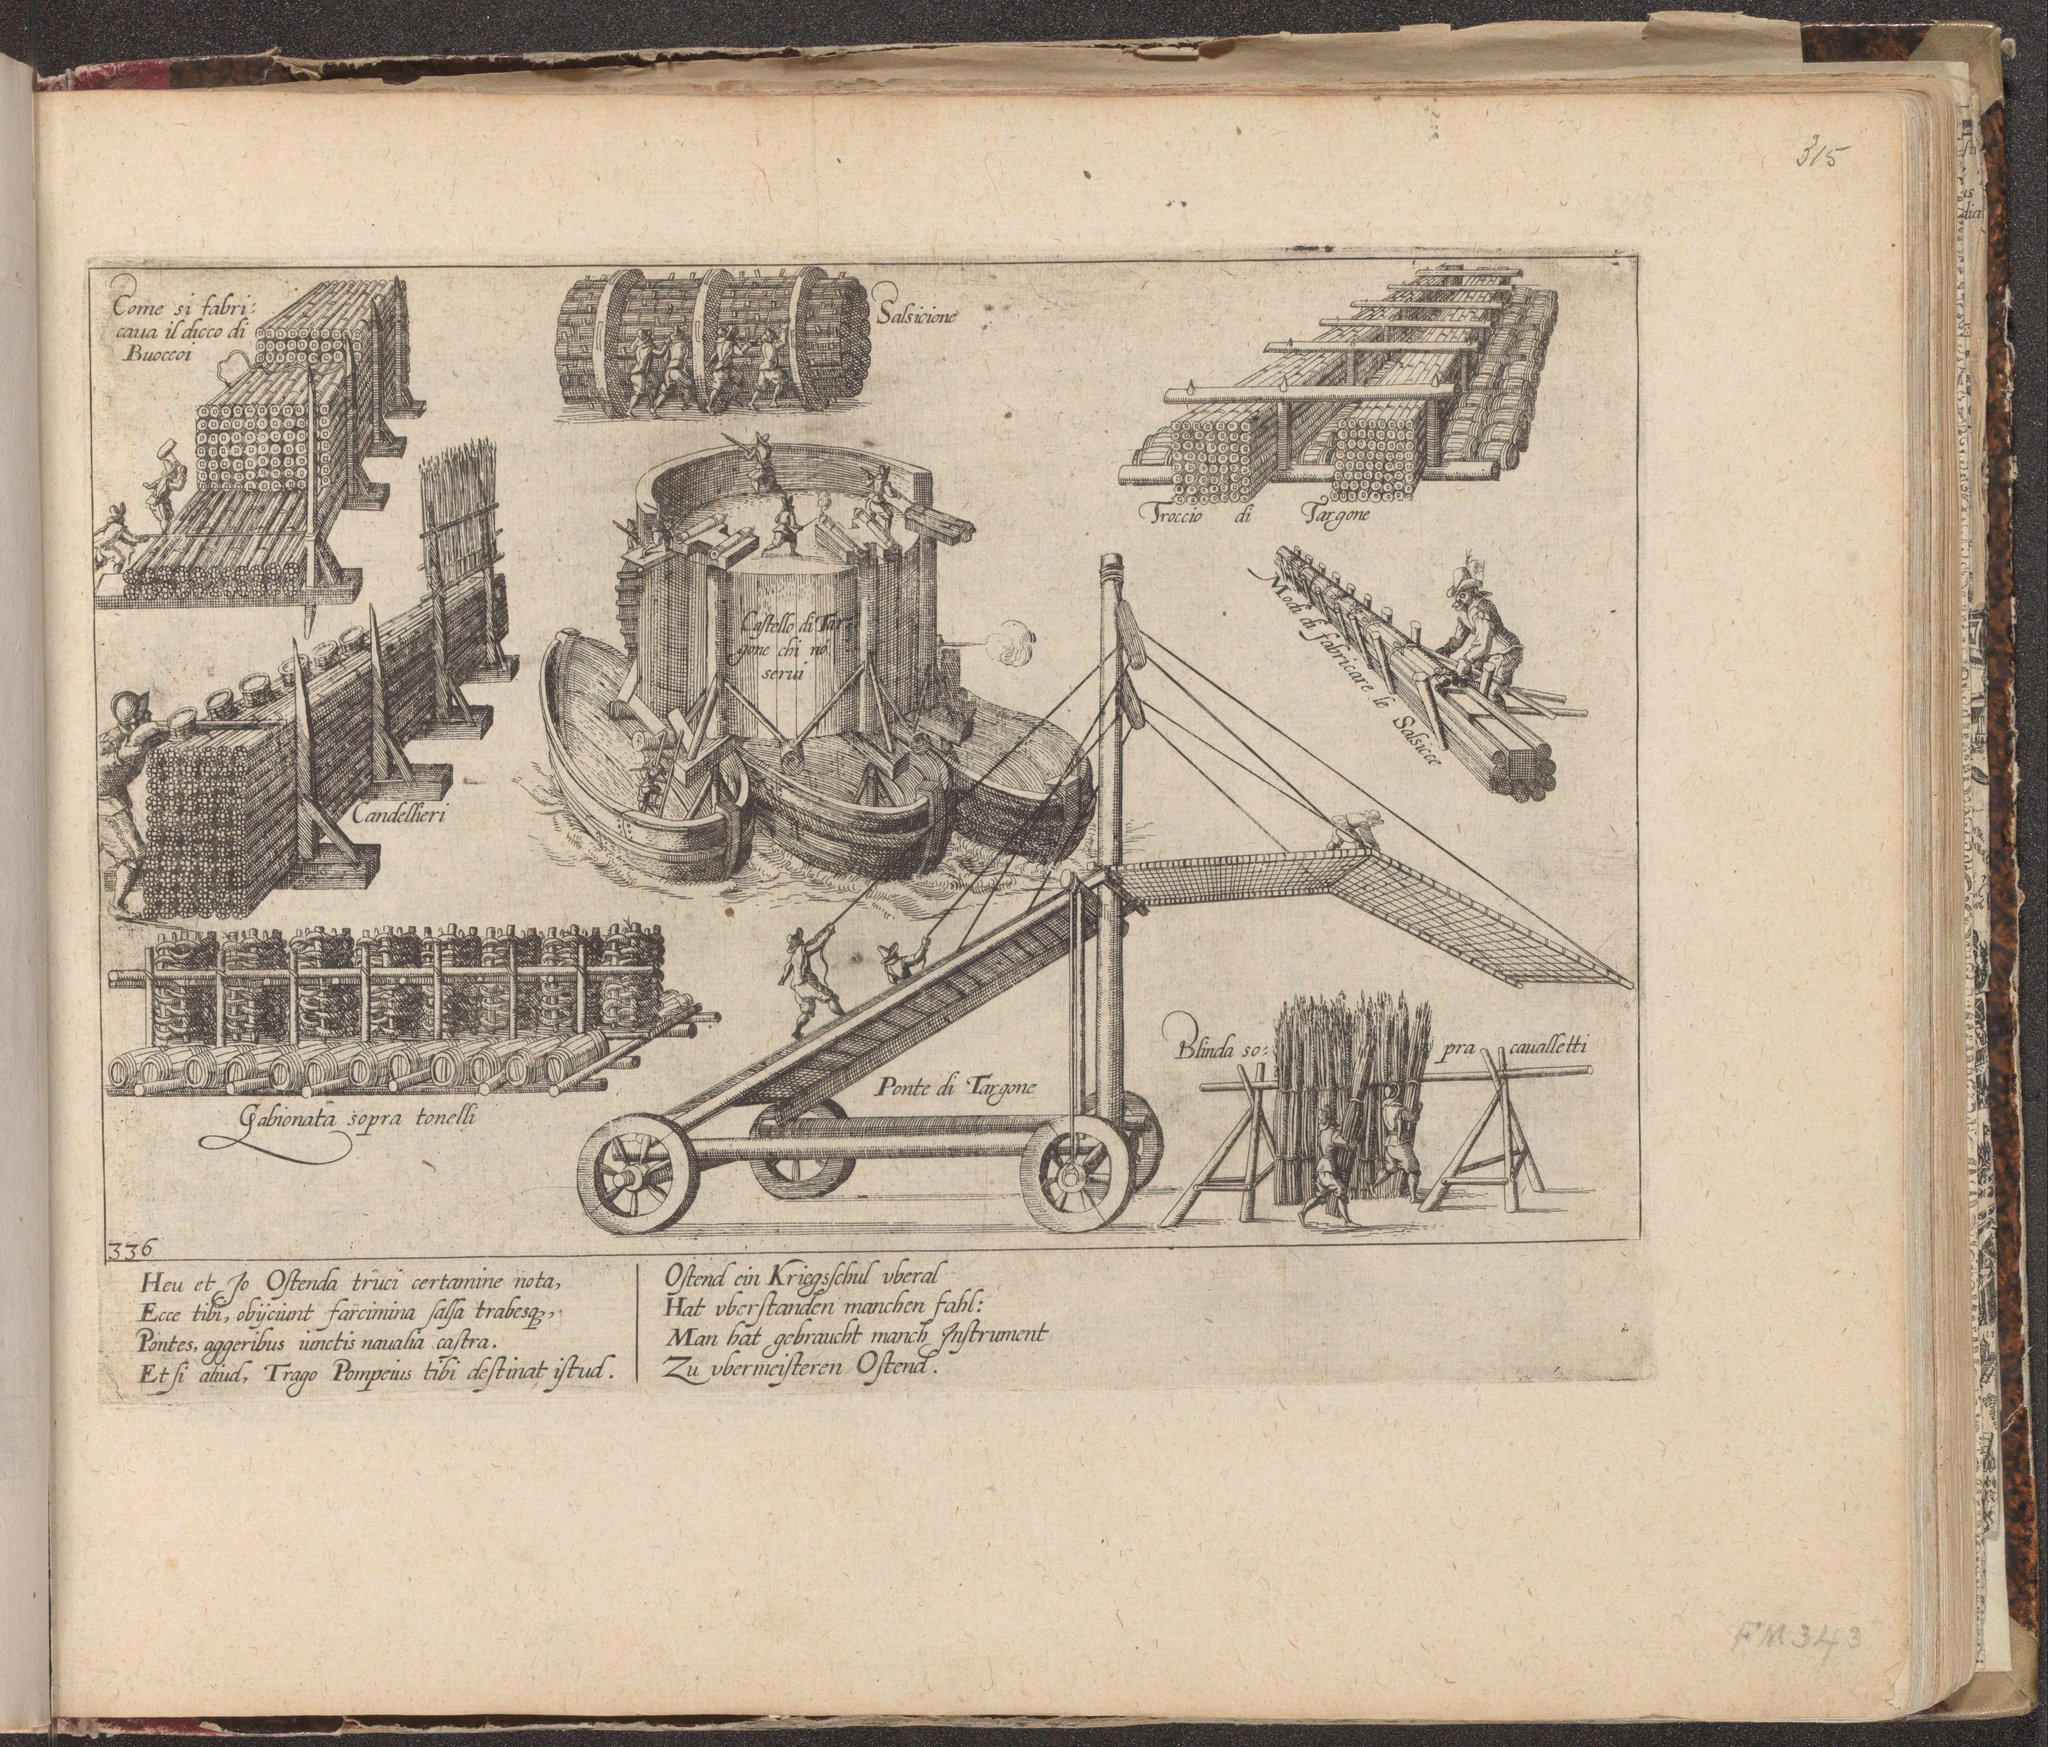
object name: album leaf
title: Serie 10: Nederlandse en Buitenlandse Gebeurtenissen, 1587-1612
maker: frans hogenberg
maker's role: print maker, publisher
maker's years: 1538-1590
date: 1601-1603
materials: paper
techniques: etching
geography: cologne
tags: protective weapons, fortifications, military engineering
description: Moderne belegeringswerktuigen ingezet door de troepen van aartshertog Albrecht bij het beleg van Oostende, 1601-1604. Opschriften in de voorstelling in het Italiaans. Met onderschrift van 4 regels in het Latijn en 4 regels in het Duits. Linksonder genummerd: 336. De prent maakt deel uit van een album.